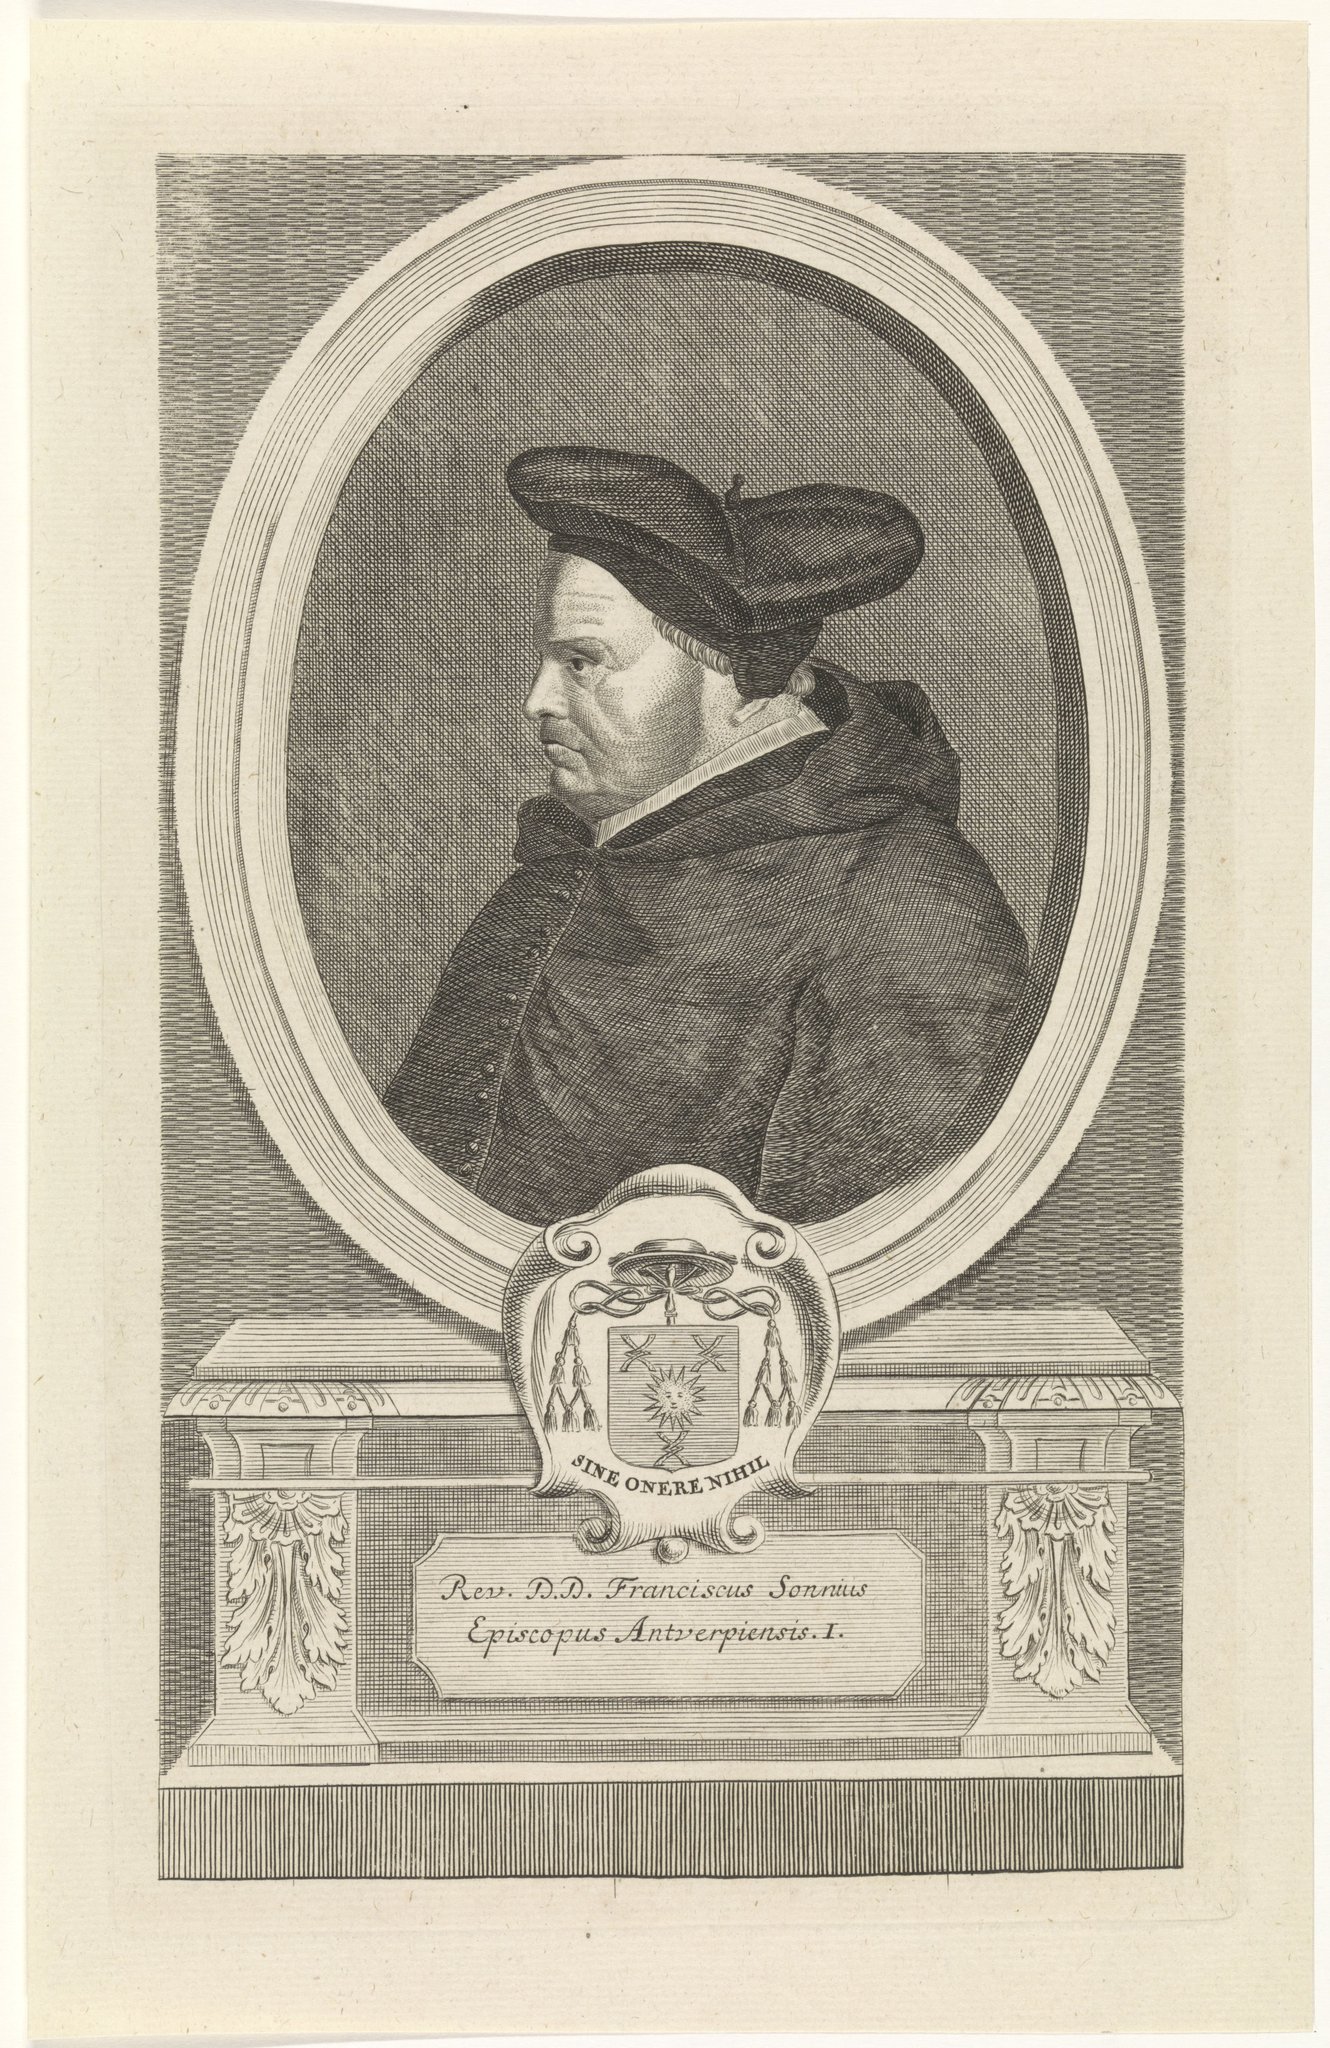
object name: book illustration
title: Portret van Franciscus Sonnius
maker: jan baptist jongelinx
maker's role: print maker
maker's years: 1689-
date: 1710-1725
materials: paper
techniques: engraving, etching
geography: antwerp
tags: antwerp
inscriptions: collector's mark: Lugt 2228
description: Busteportret van Franciscus Sonnius, met baret. Het portret is gevat in een ovale omlijsting met het wapenschild van de geportretteerde en een motto in het Latijn. In een kader een tweeregelig onderschrift in het Latijn.